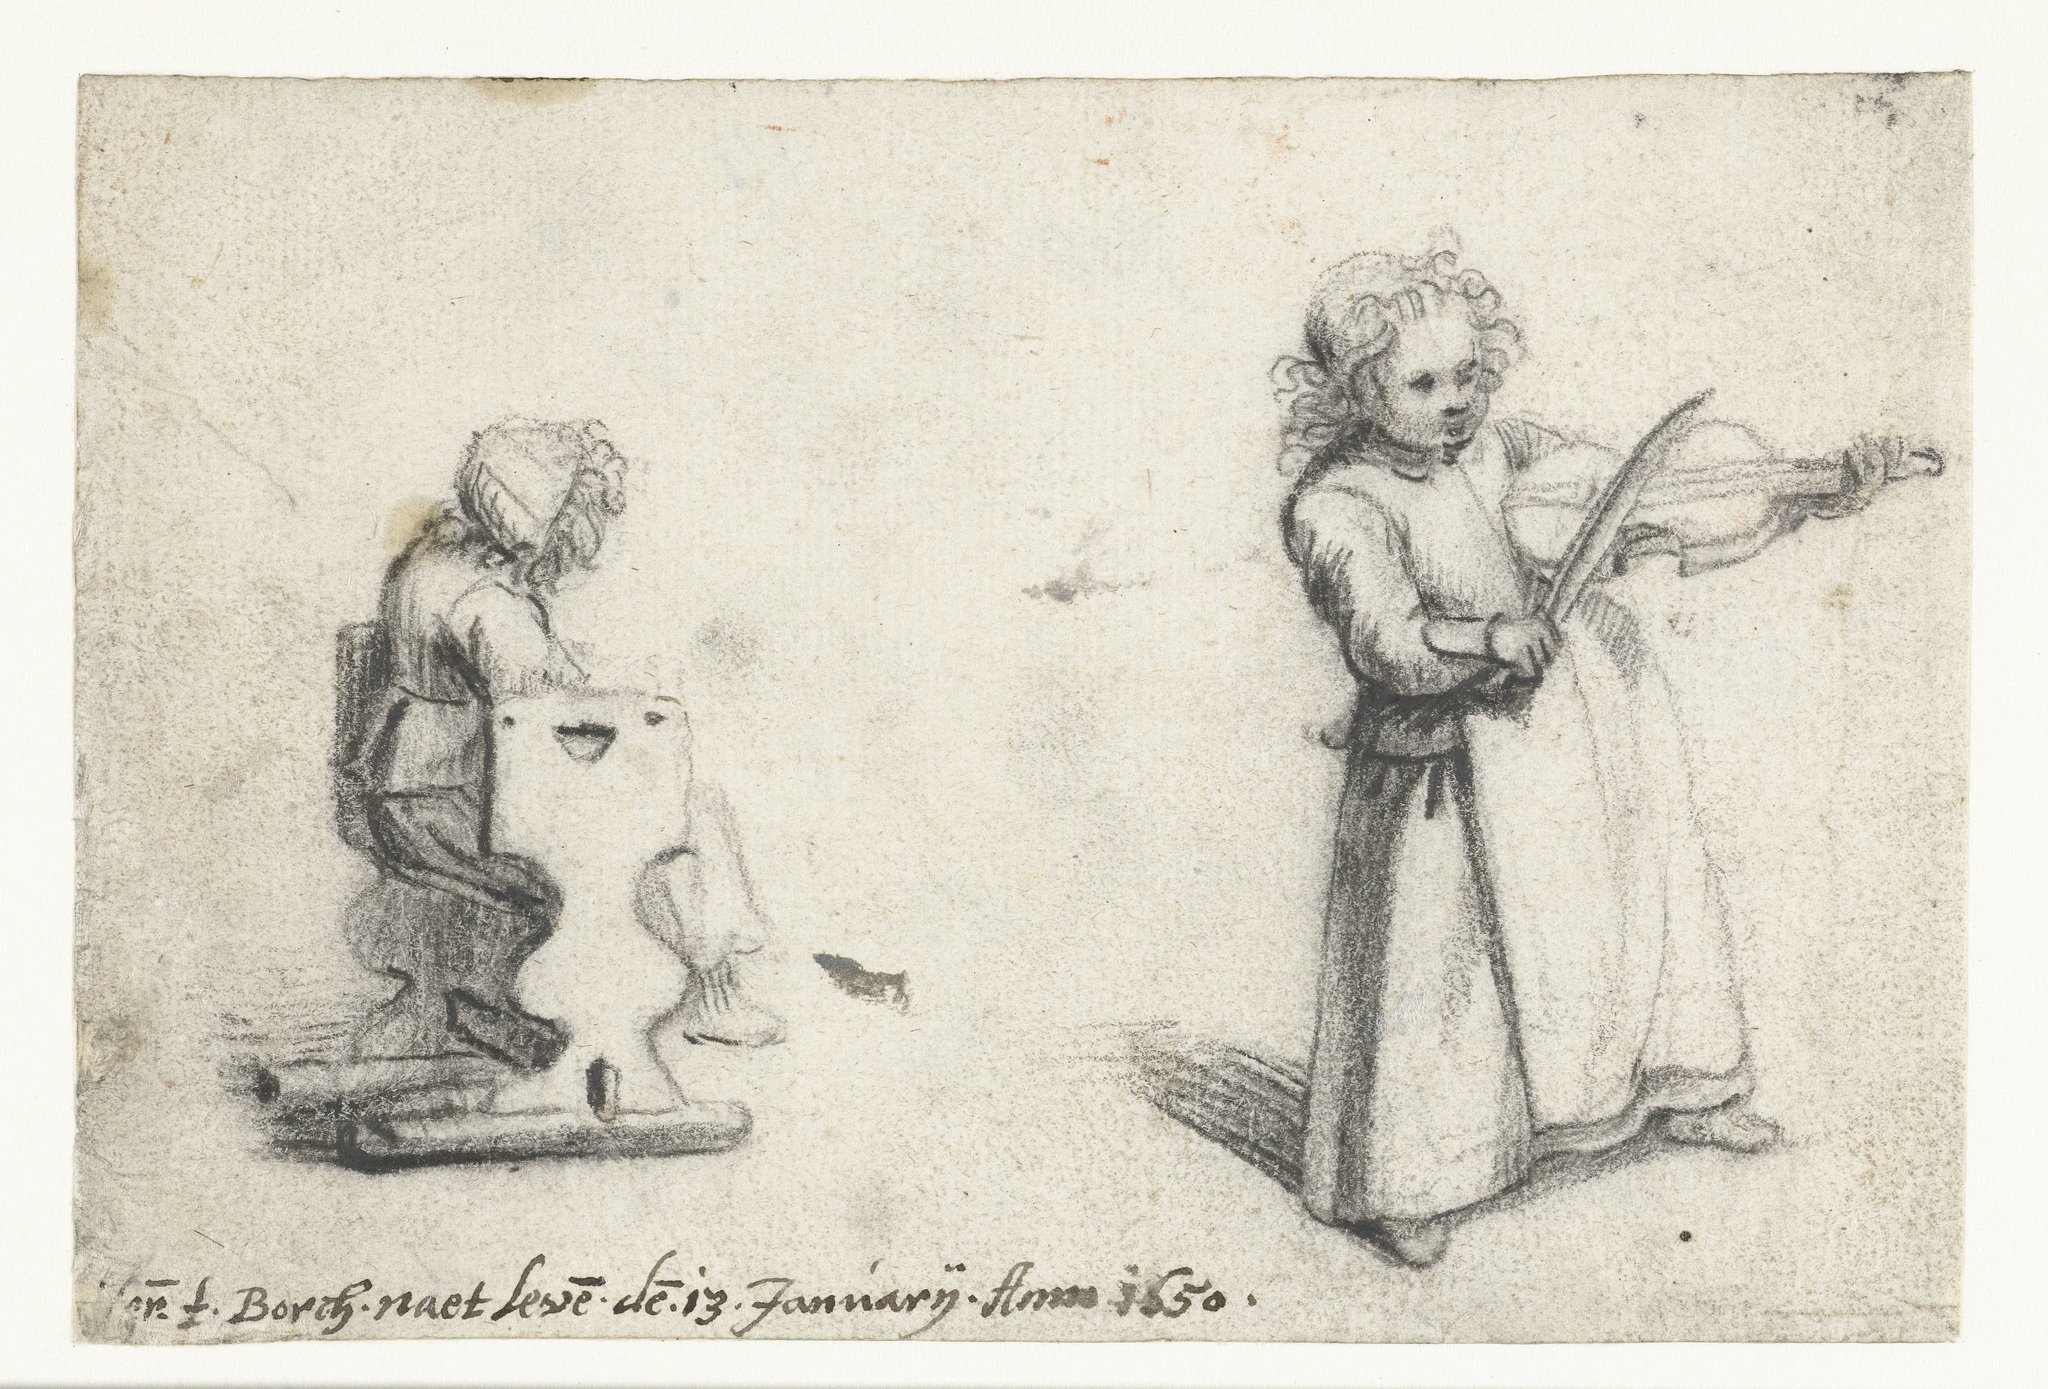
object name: drawing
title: Seated Child and a Child Playing the Violin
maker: harmen ter borch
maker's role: draughtsman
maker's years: 1638-1677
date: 1650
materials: chalk, paper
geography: zwolle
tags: one person playing string instrument (bowed)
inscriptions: annotation: ‘Har[men].t.Borch. naet leve[n]. de[n].13. Januarij. Anno 1650’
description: Harmen ter Borch was the most prolific member of his artistic family. Over 200 drawings can be attributed to him. Many sheets bear notes and dates written by his father, Gerard ter Borch. From this emerges that Harmen drew chiefly in the winter months, when it was too cold to venture outdoors.